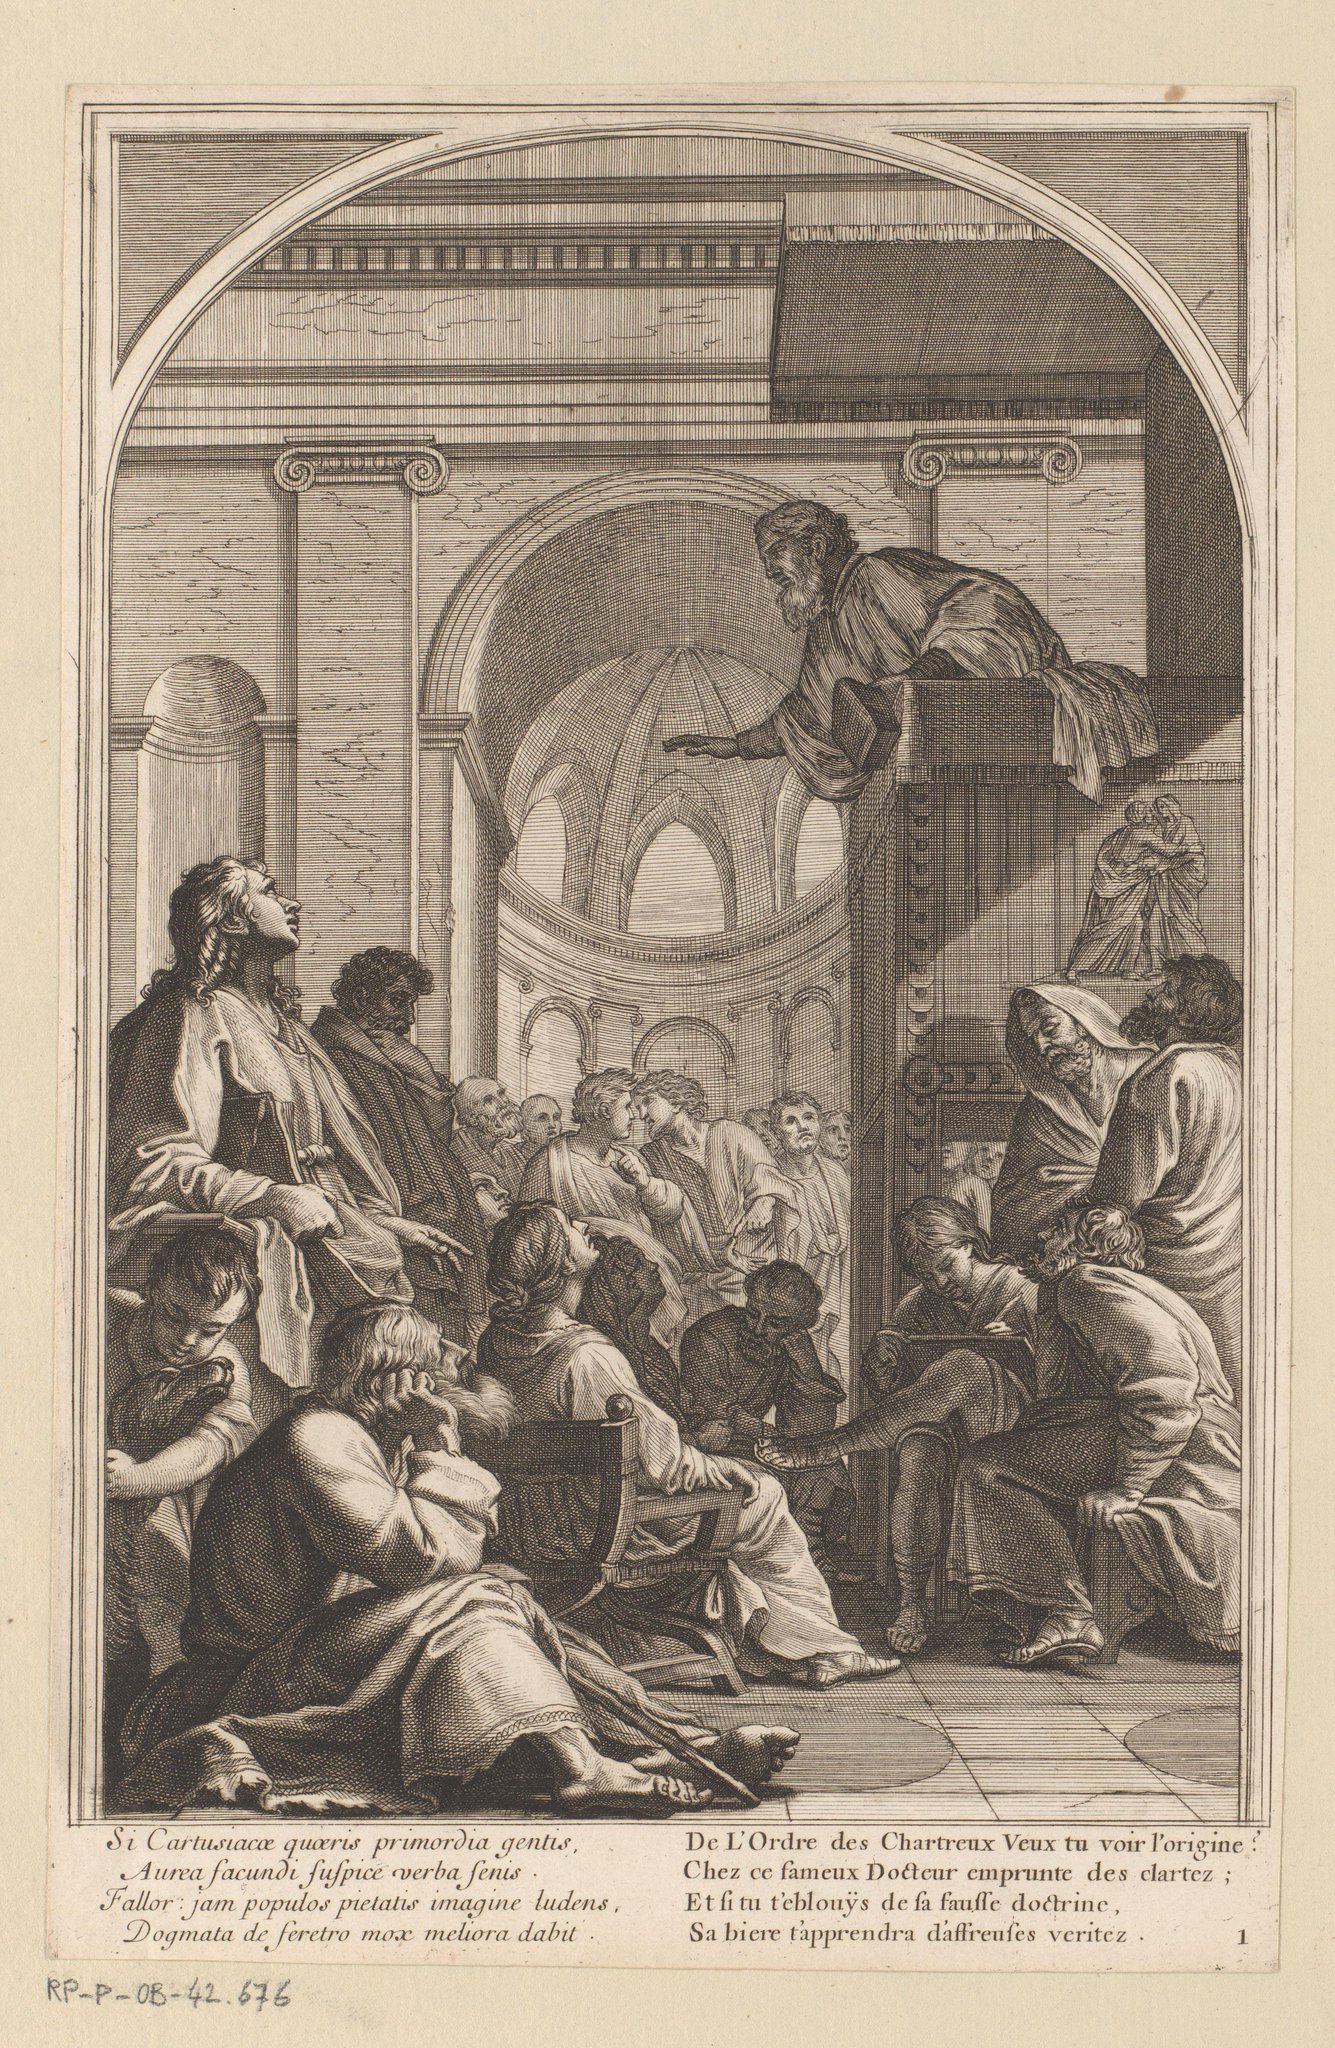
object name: print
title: Heilige Bruno bij de preek van Raymond Diocrès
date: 1623-1676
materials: paper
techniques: engraving, etching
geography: paris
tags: the founder of the order of the carthusians, bruno; possible attributes: cross, finger at lips, lily, mitre at his feet, olive-branch, ray of light, skull, (seven) star(s), pulpit, ambo, chancel, preaching (in general)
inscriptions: collector's mark: Lugt 2165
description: Maakt deel uit van een serie met 24 prenten (inclusief twee titelprenten), naar schilderijen door Lesueur vervaardigd tussen 1645-1648 voor de Chartreuse de Paris. De serie is getiteld: La vie de St. Bruno fondateur de l'Ordre des Chartreux peinte au cloistre de la Chartreuse de Paris par Eustache Le Sueur.